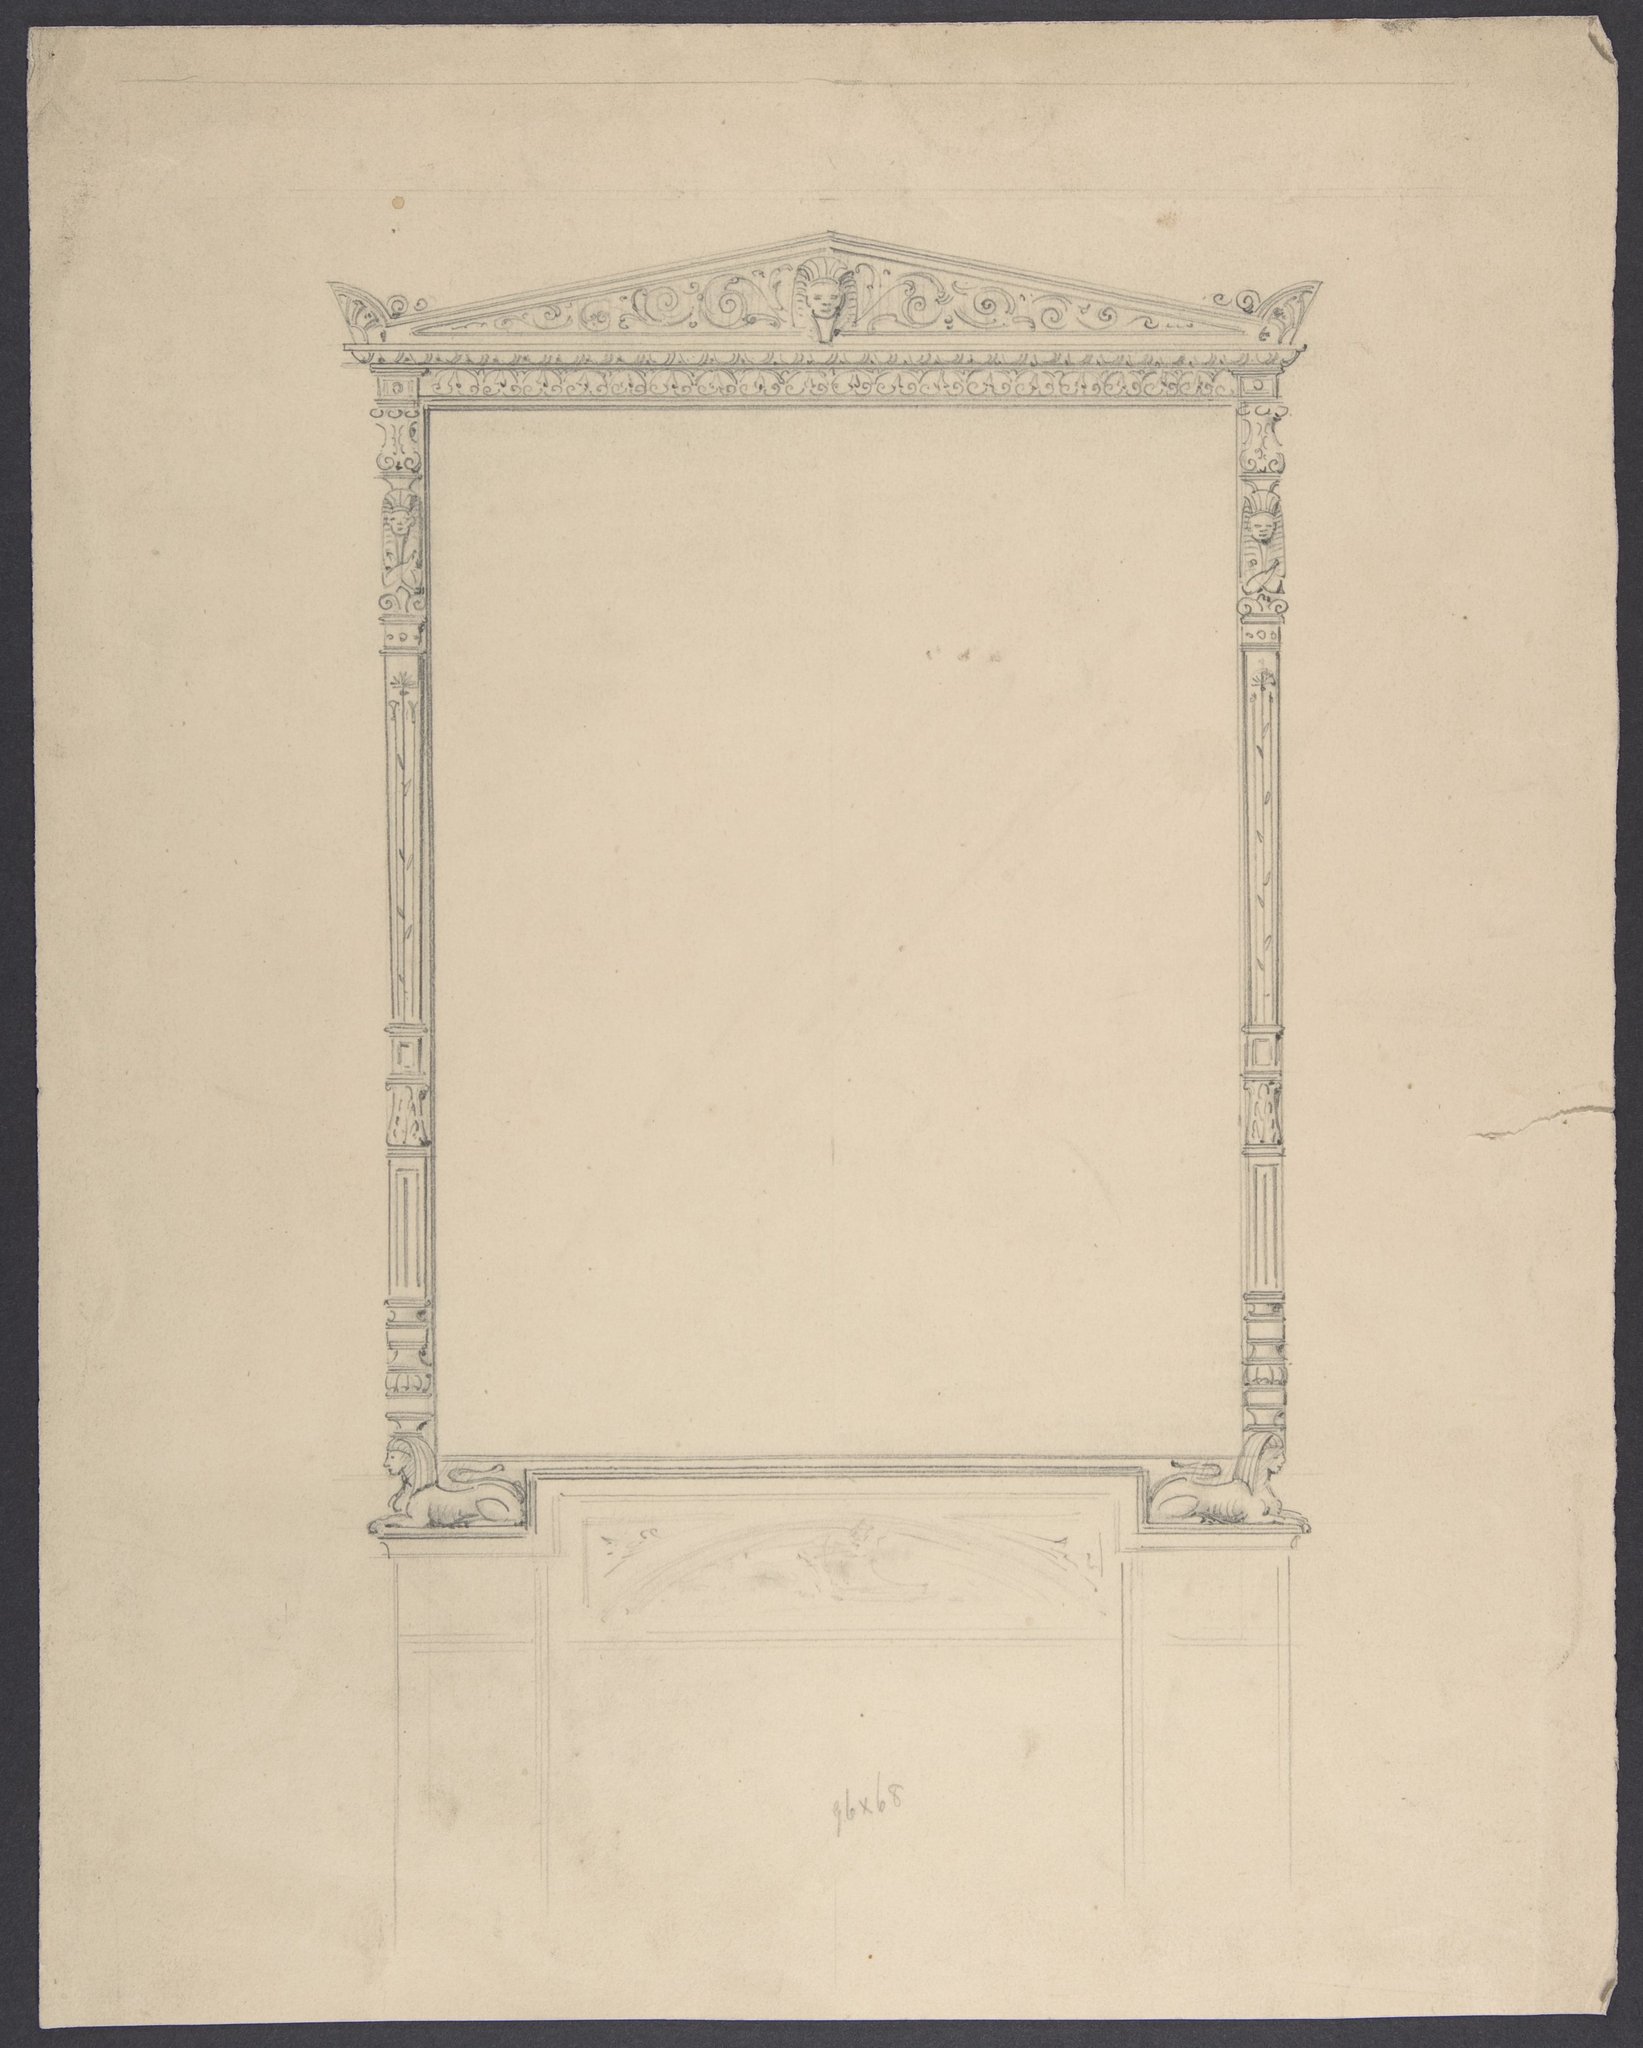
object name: drawing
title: Design for an Over-Mantle Mirror Frame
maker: anonymous, french, 19th century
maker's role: artist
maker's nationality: french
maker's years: 1800-1900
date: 1801-1900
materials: graphite